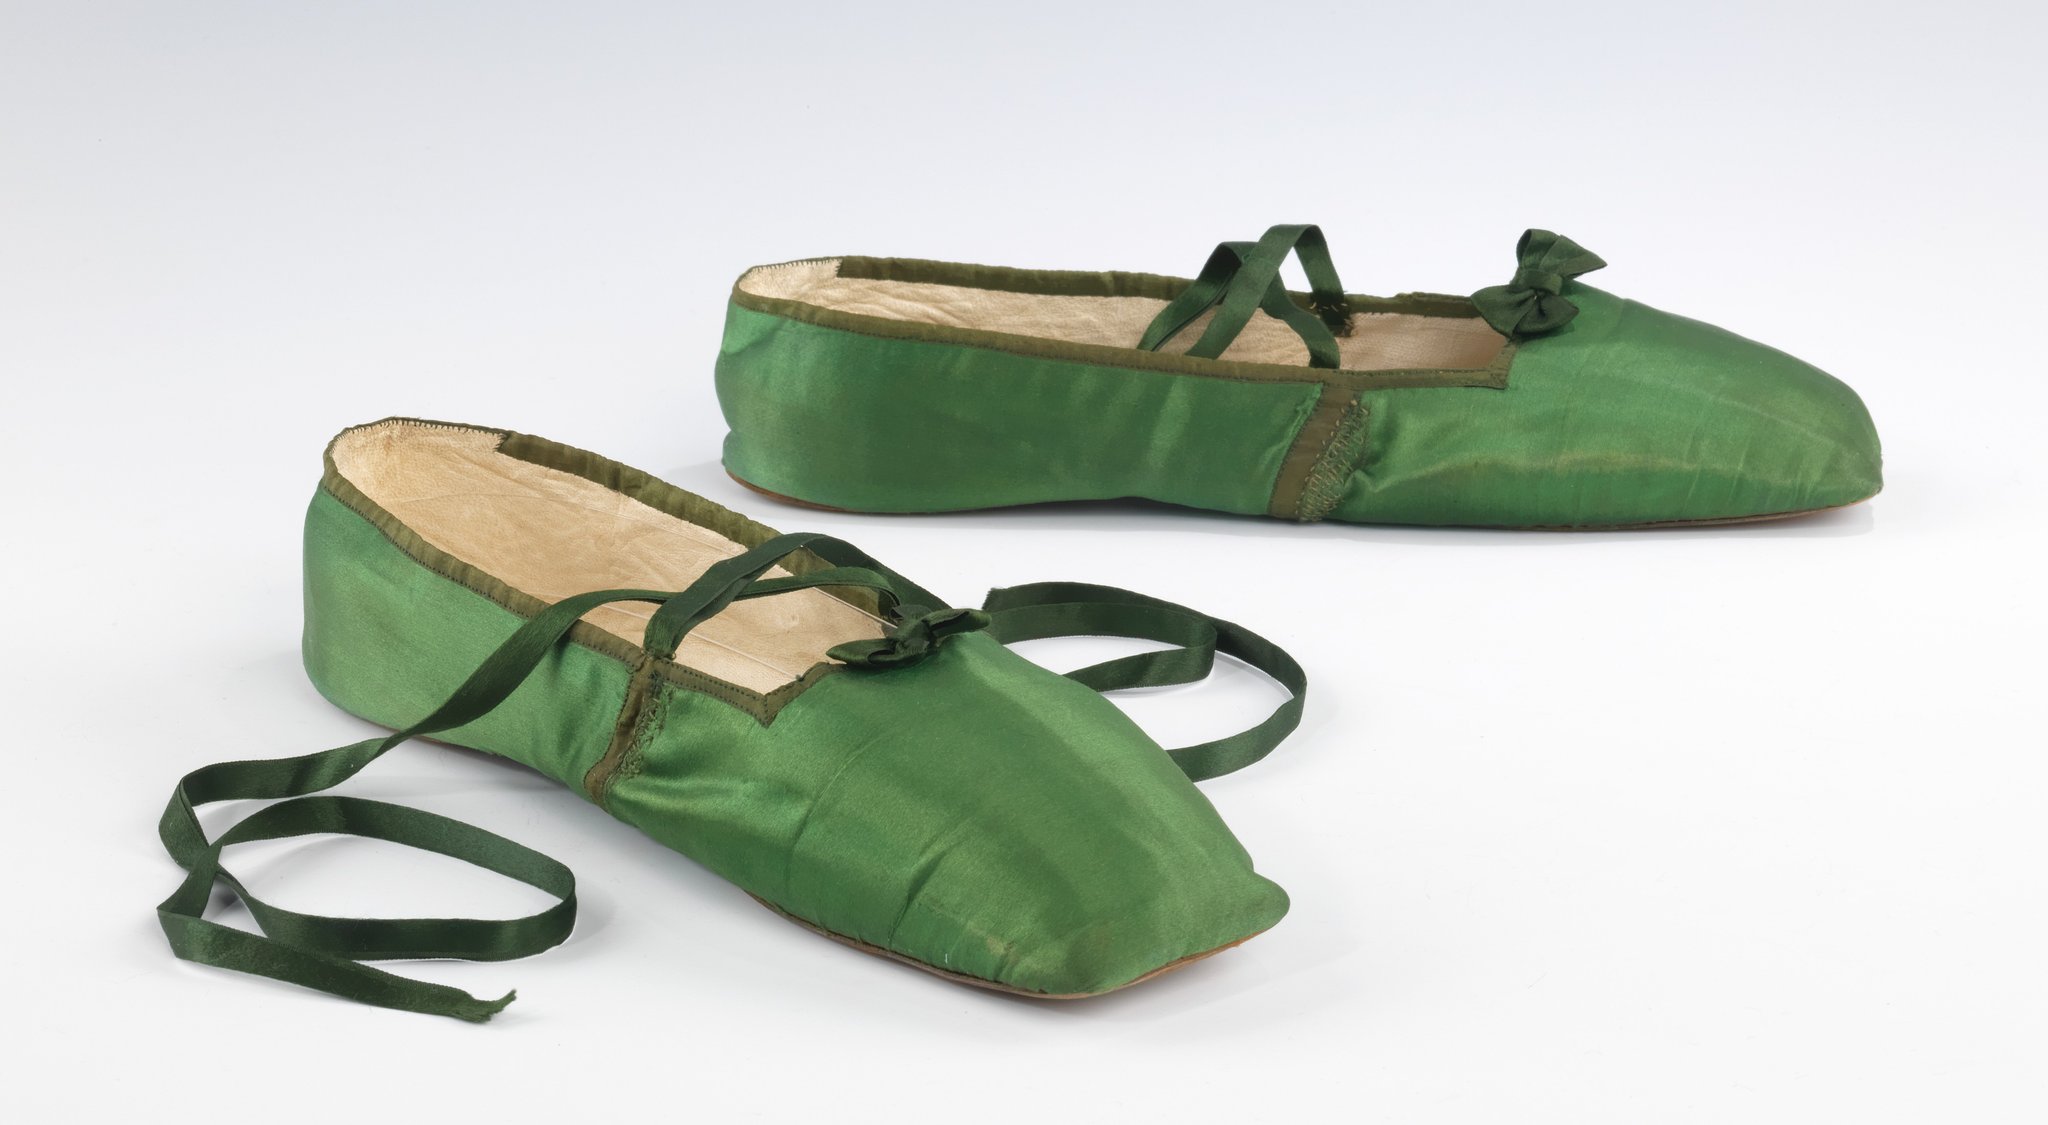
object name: evening slipper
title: Evening slippers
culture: american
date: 1835-1845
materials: silk